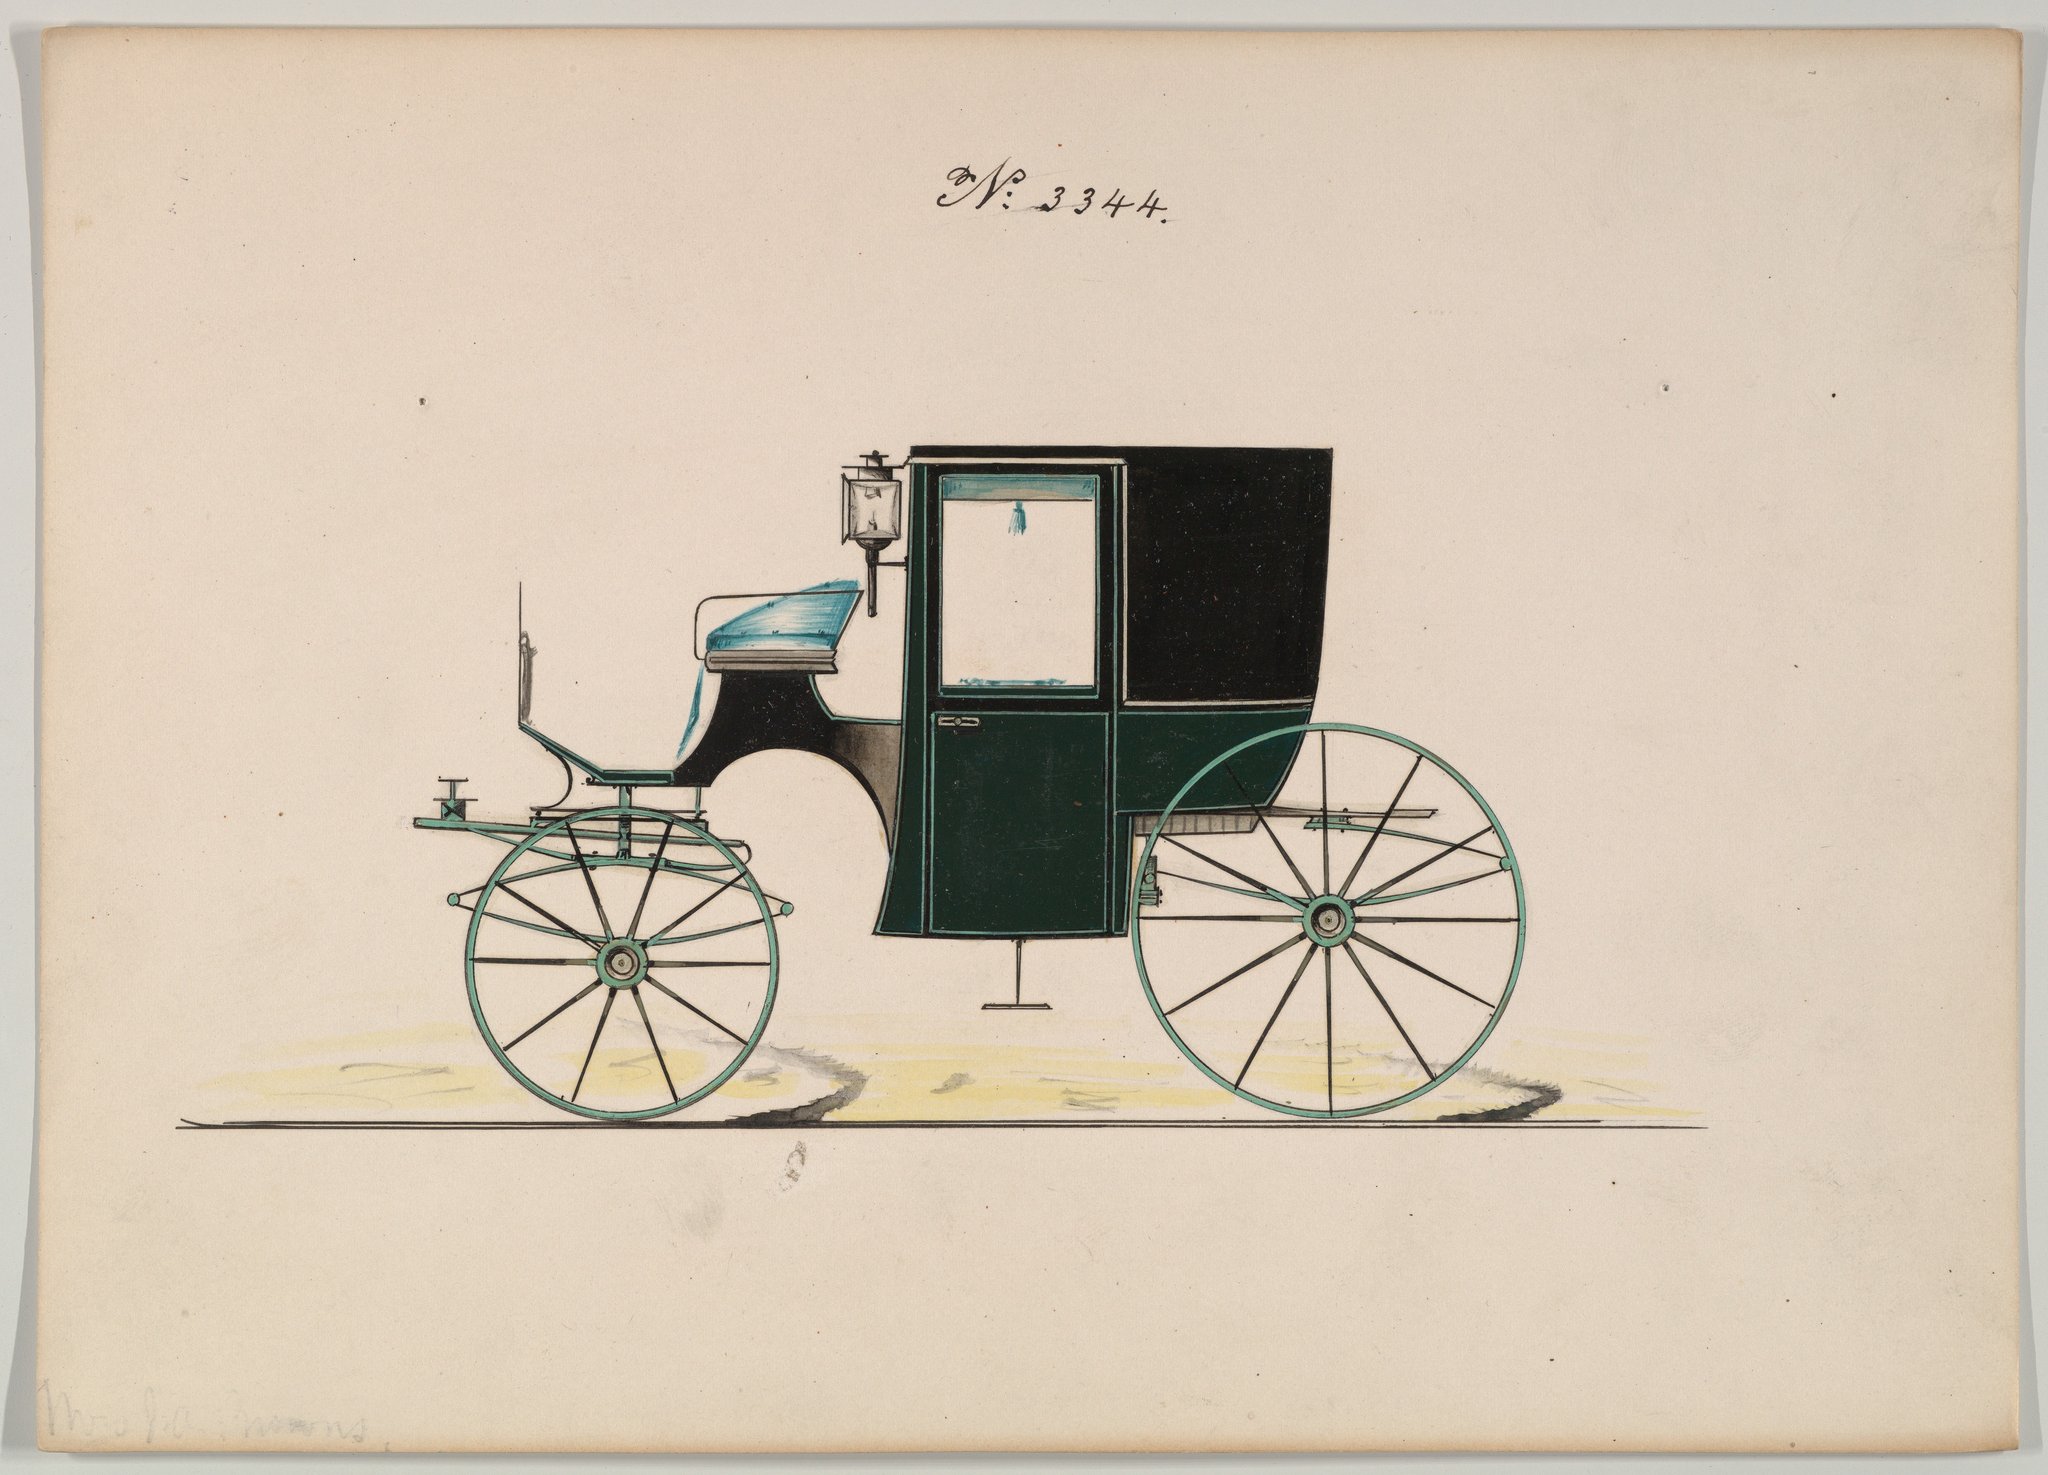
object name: drawing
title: Brougham #3344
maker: brewster & co.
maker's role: manufacturer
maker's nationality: american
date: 1877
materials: gouache, gum arabic, ink, watercolor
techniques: pen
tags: carriages